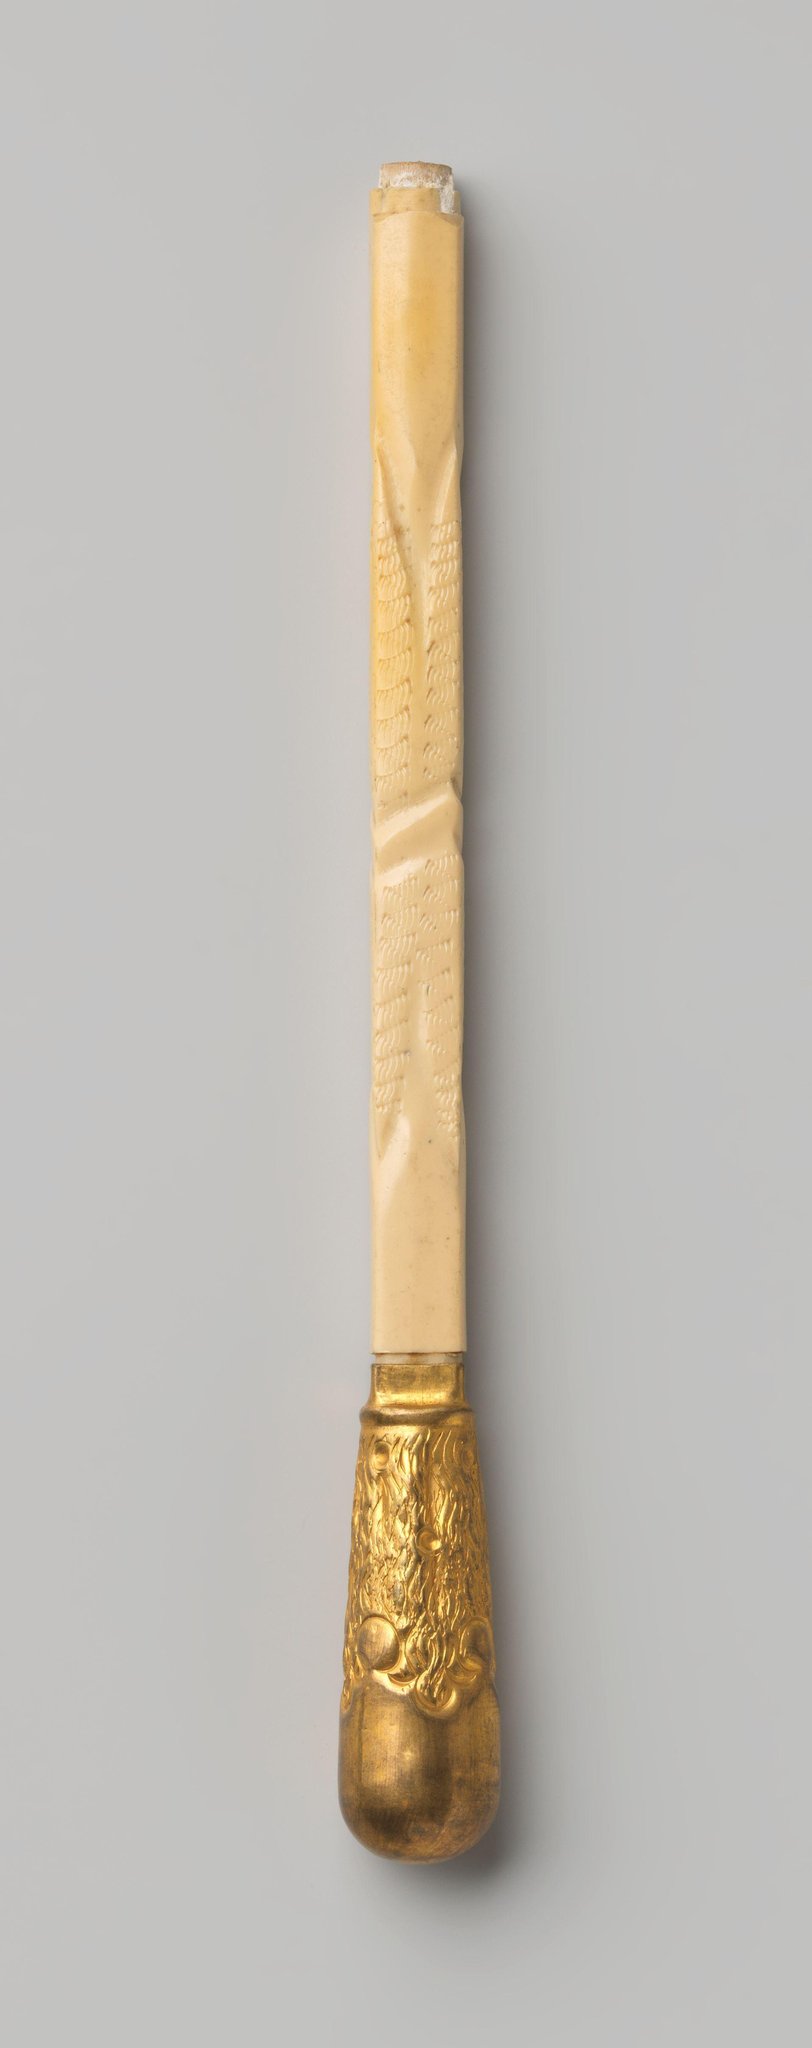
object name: parapluknop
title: Met been bekleed handvat voor een paraplu of parasol; met een vergulde ronde knop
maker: gustav schnitzler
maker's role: paraplufabrikant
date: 1910-1920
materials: bone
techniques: cutting, gilding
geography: nijmegen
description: Met been bekleed handvat met vierkante doorsnede, voor een paraplu of parasol. Het been is versierd. Aan het handvat zit een vergulde ronde knop.